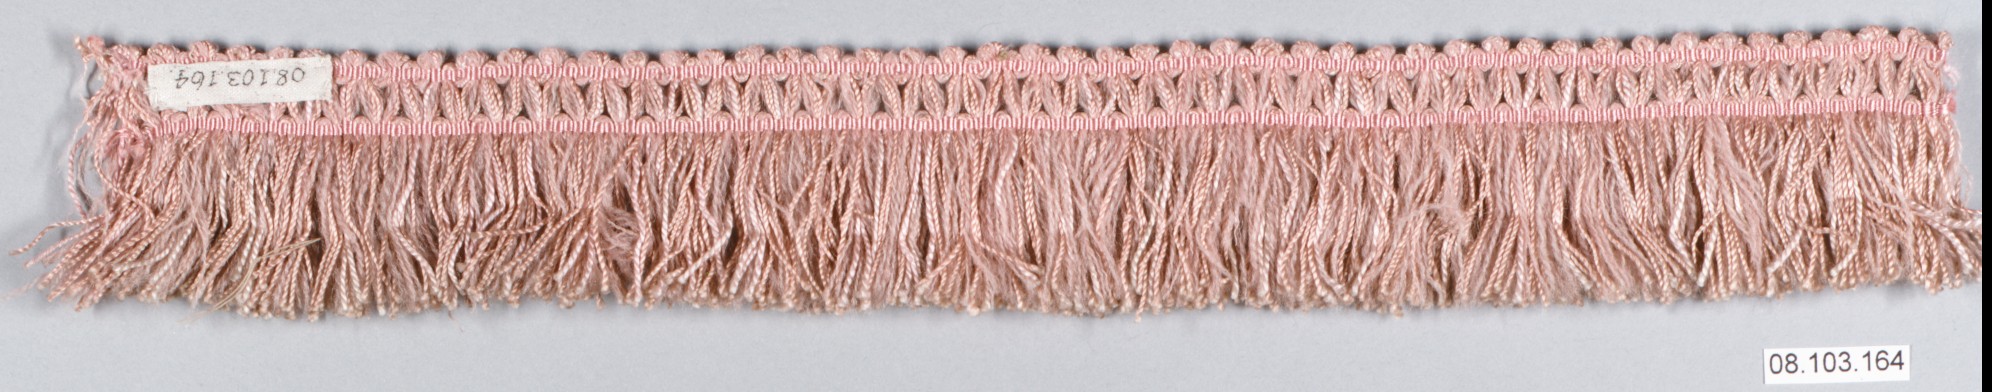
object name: fringe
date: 1801-1900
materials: silk, wool